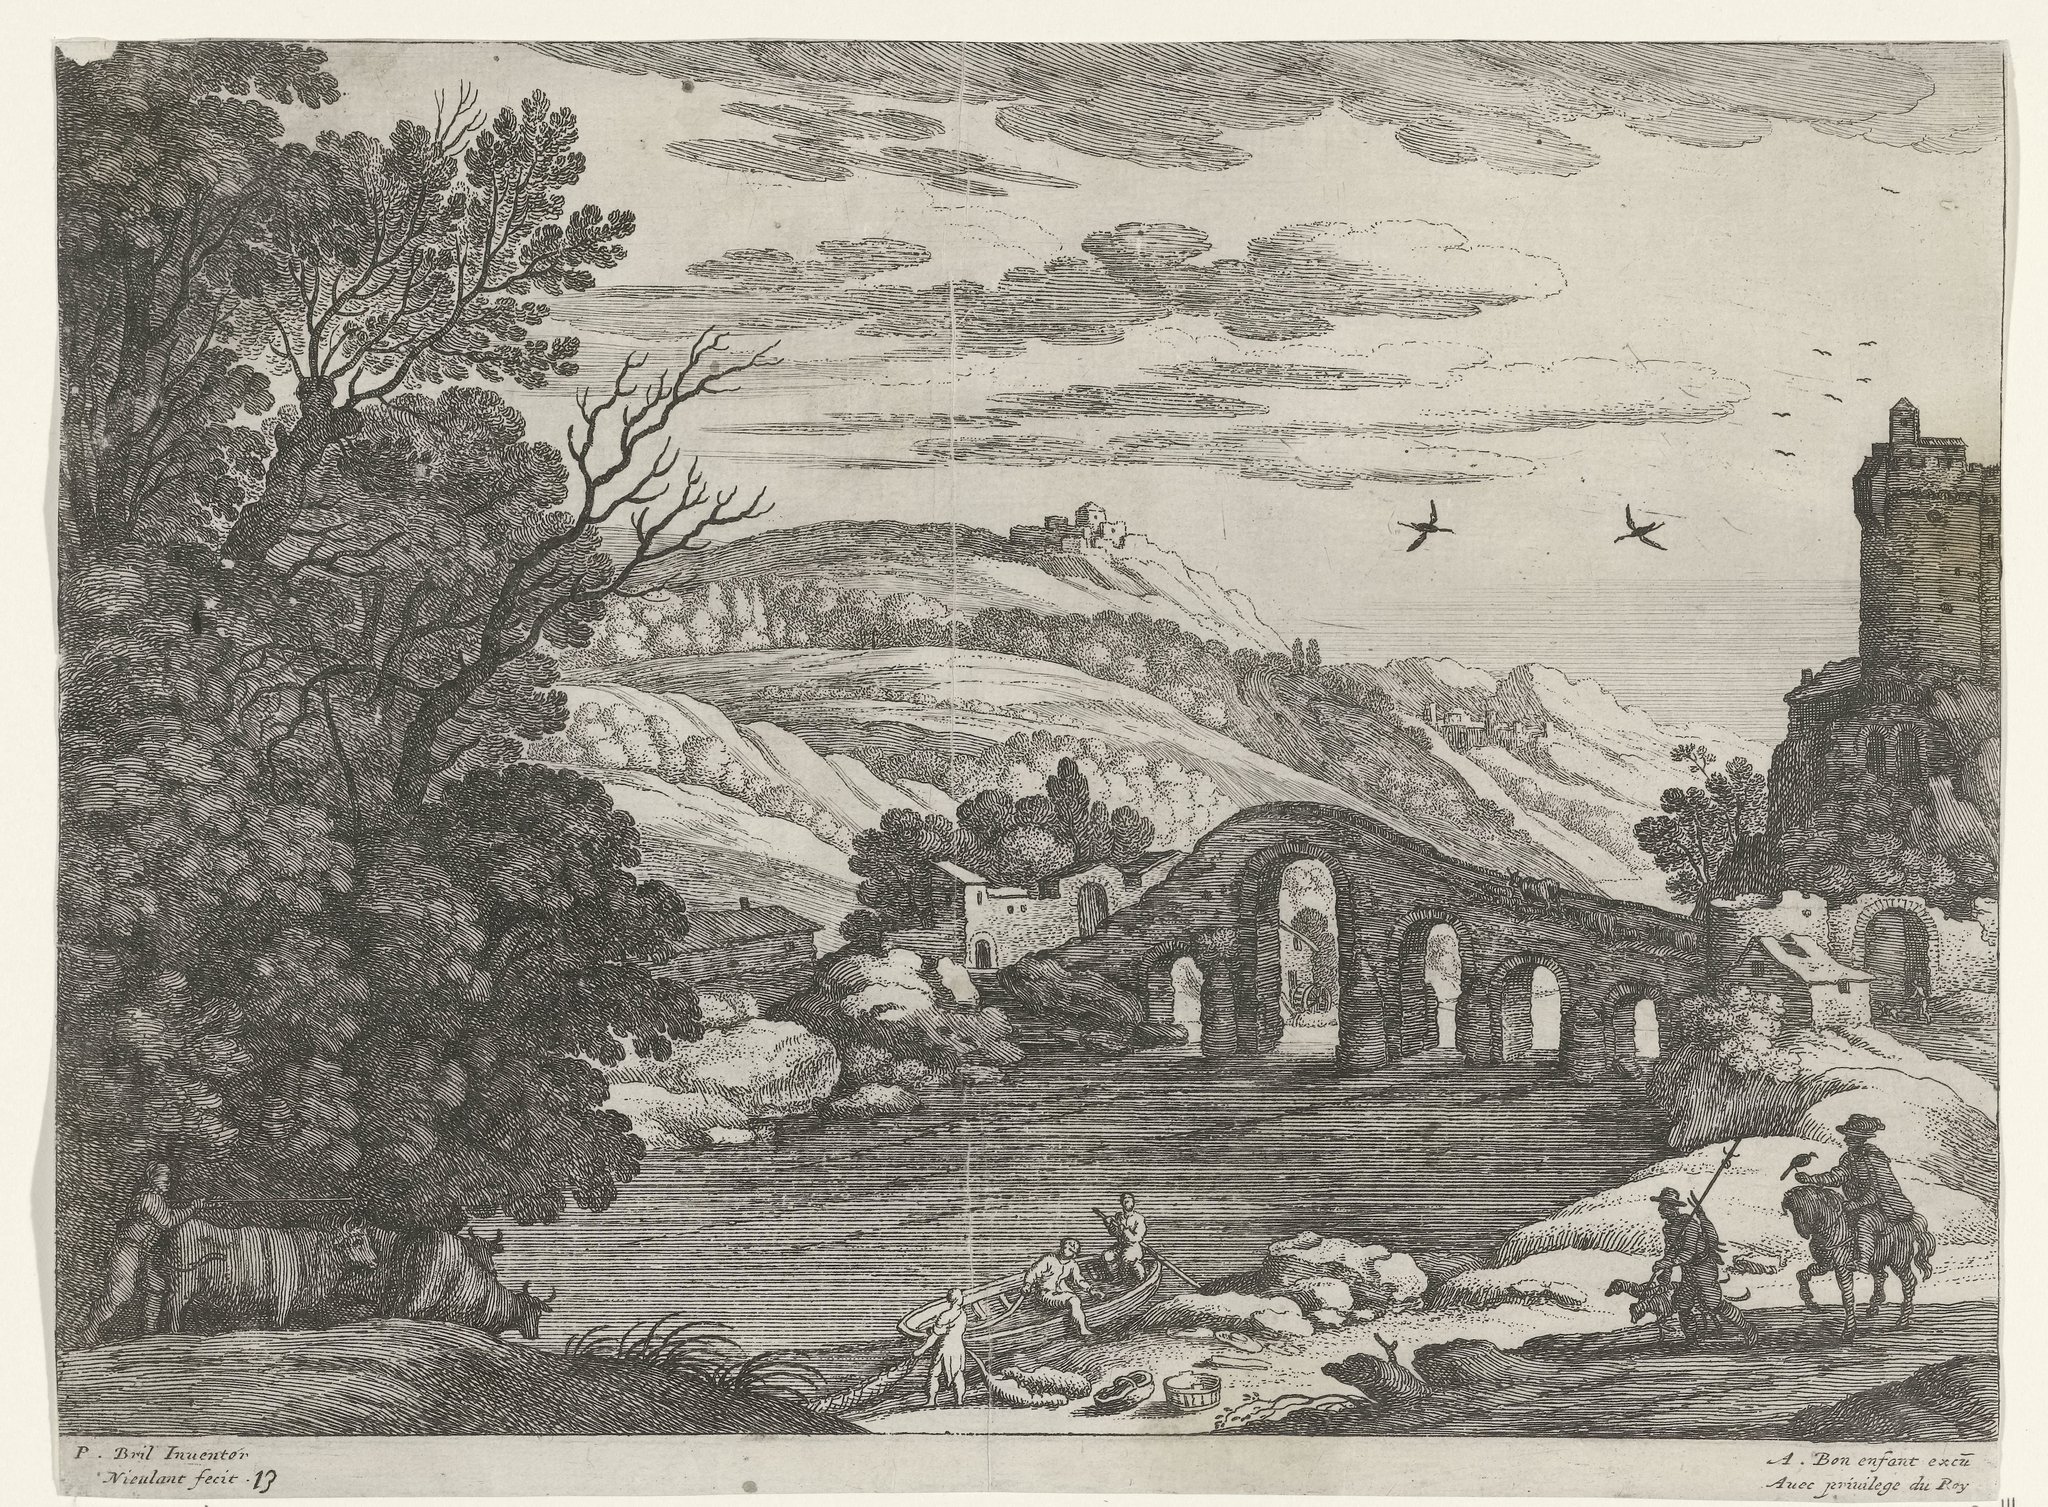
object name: print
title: Italiaanse landschappen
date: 1594-1635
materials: paper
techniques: engraving, etching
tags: predatory birds: falcon, hunting dogs, hunter, cattle driving, cattle driver, landscape with bridge, viaduct or aqueduct - ii - ideal landscapes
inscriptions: collector's mark: Lugt 2228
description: Een heuvelachtig landschap wordt doorsneden door een rivier. Over de rivier een stenen brug met vijf bogen. Aan de wal ligt een roeiboot met daarin twee mannen. Een derde man is bezig met een vissersnet. Rechts komen twee jagers aan, de één met jachthonden, de ander te paard met een valk op de arm. Links een koeiendrijver. Prent uit een serie Italiaanse landschappen.